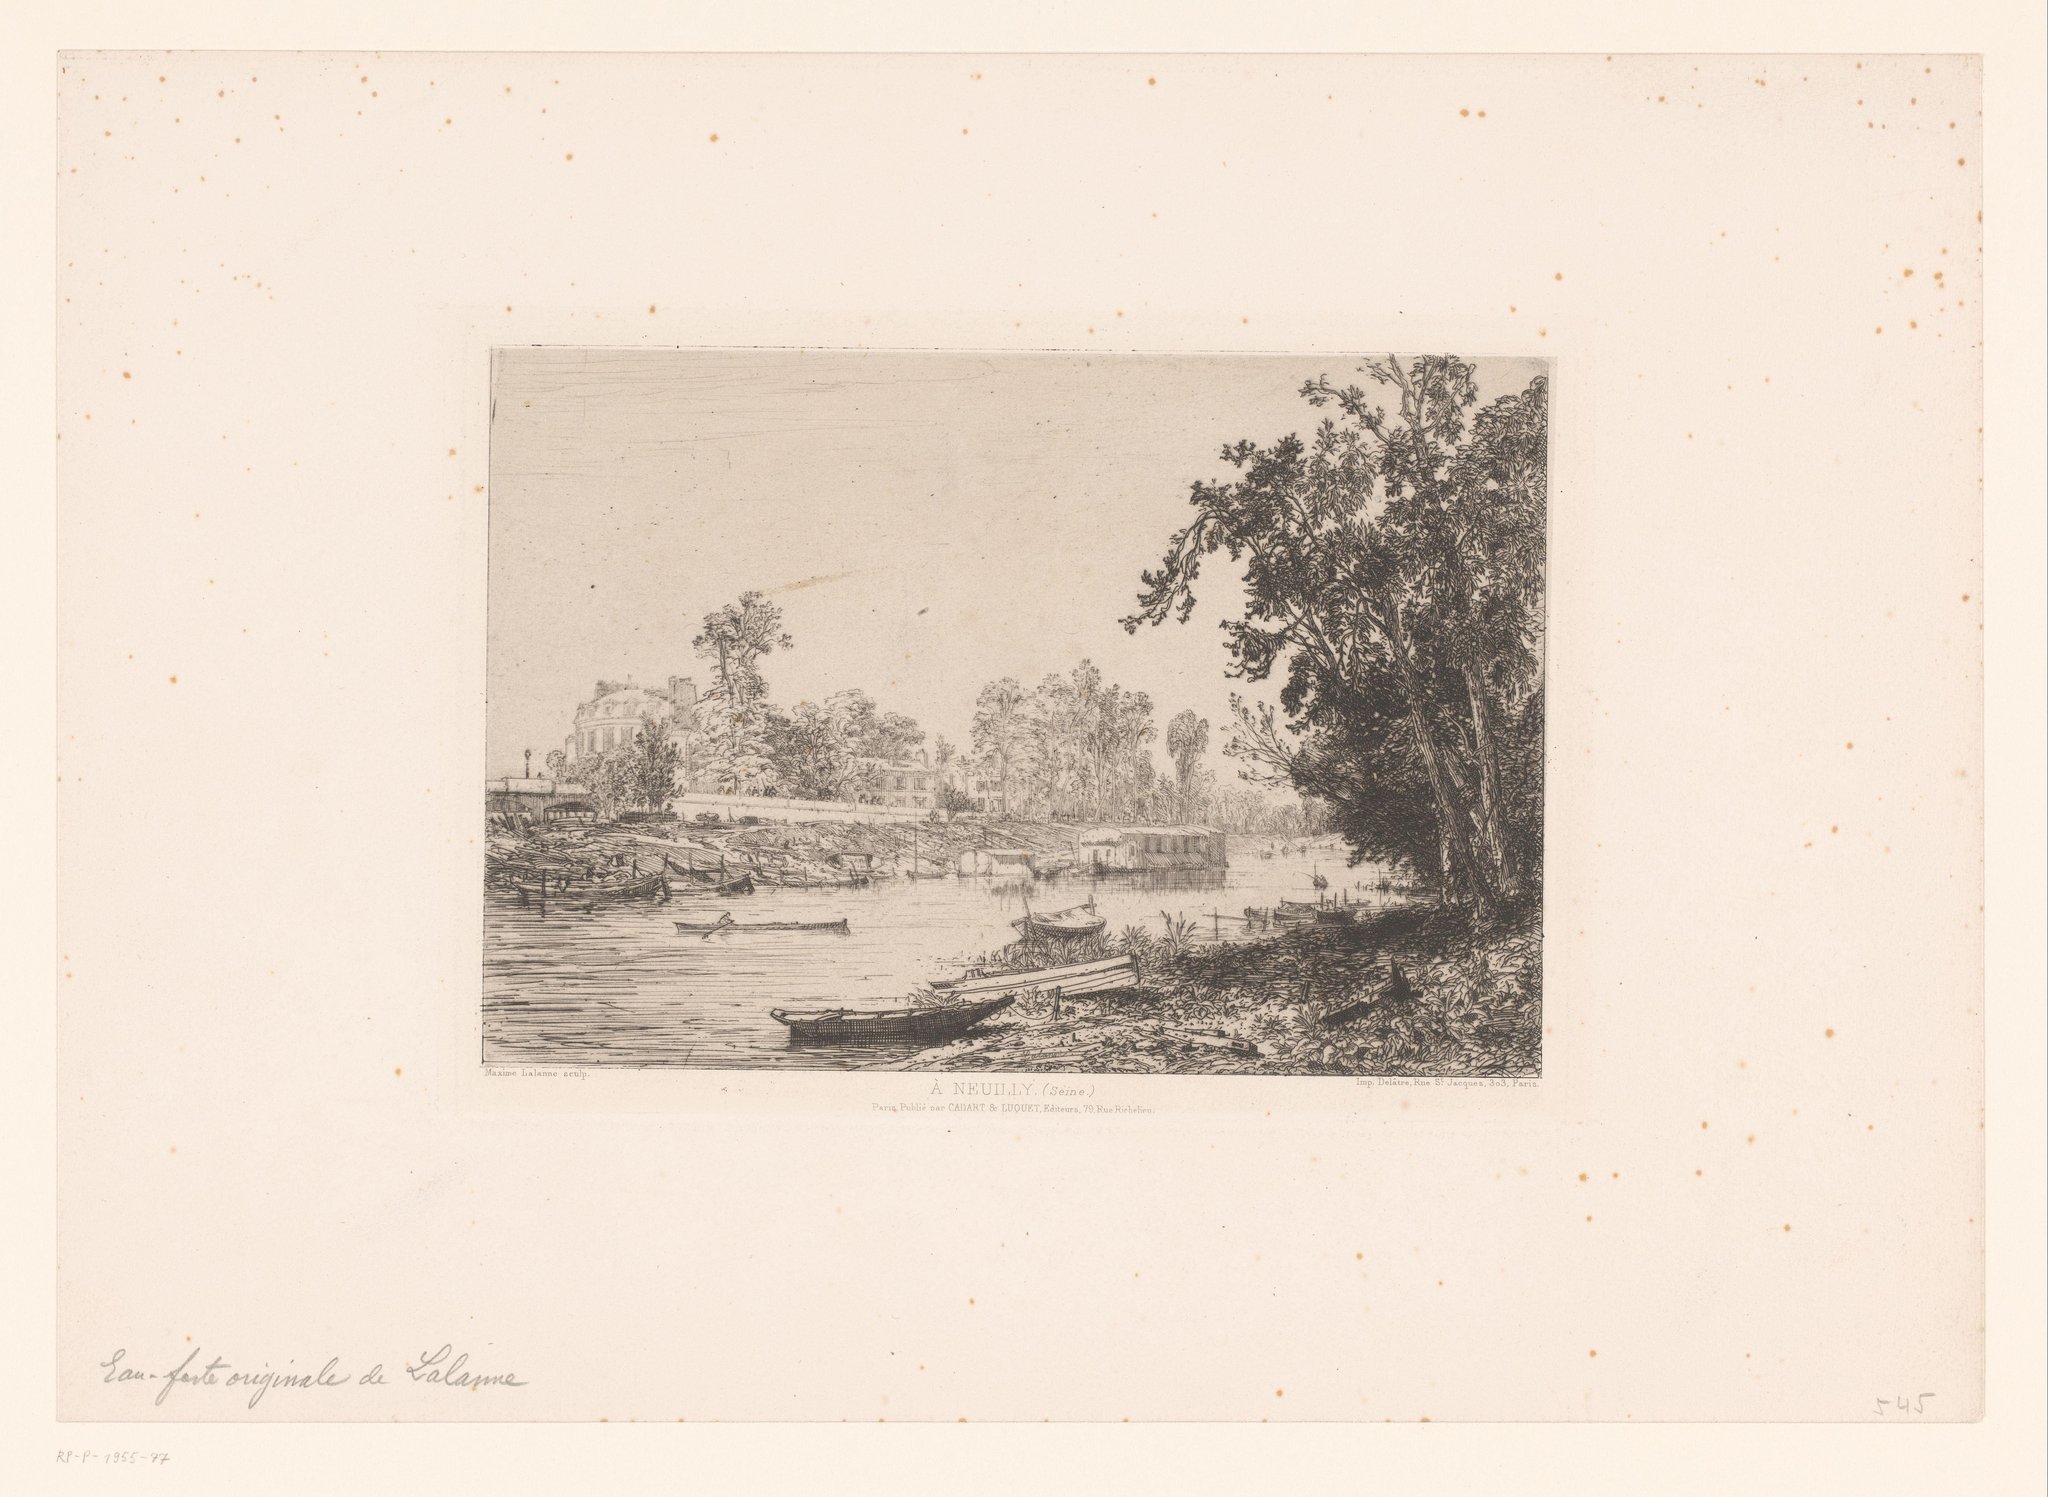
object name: print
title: Gezicht op de Seine te Neuilly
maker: maxime françois antoine lalanne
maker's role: draughtsman, print maker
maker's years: 1827-1886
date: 1863-1864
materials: paper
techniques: drypoint, etching, intaglio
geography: paris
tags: city-view, and landscape with man-made constructions - ii - ideal landscapes, river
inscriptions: collector's mark: Lugt 2228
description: Gemaakt voor de Société des aquafortistes (1863-1864).